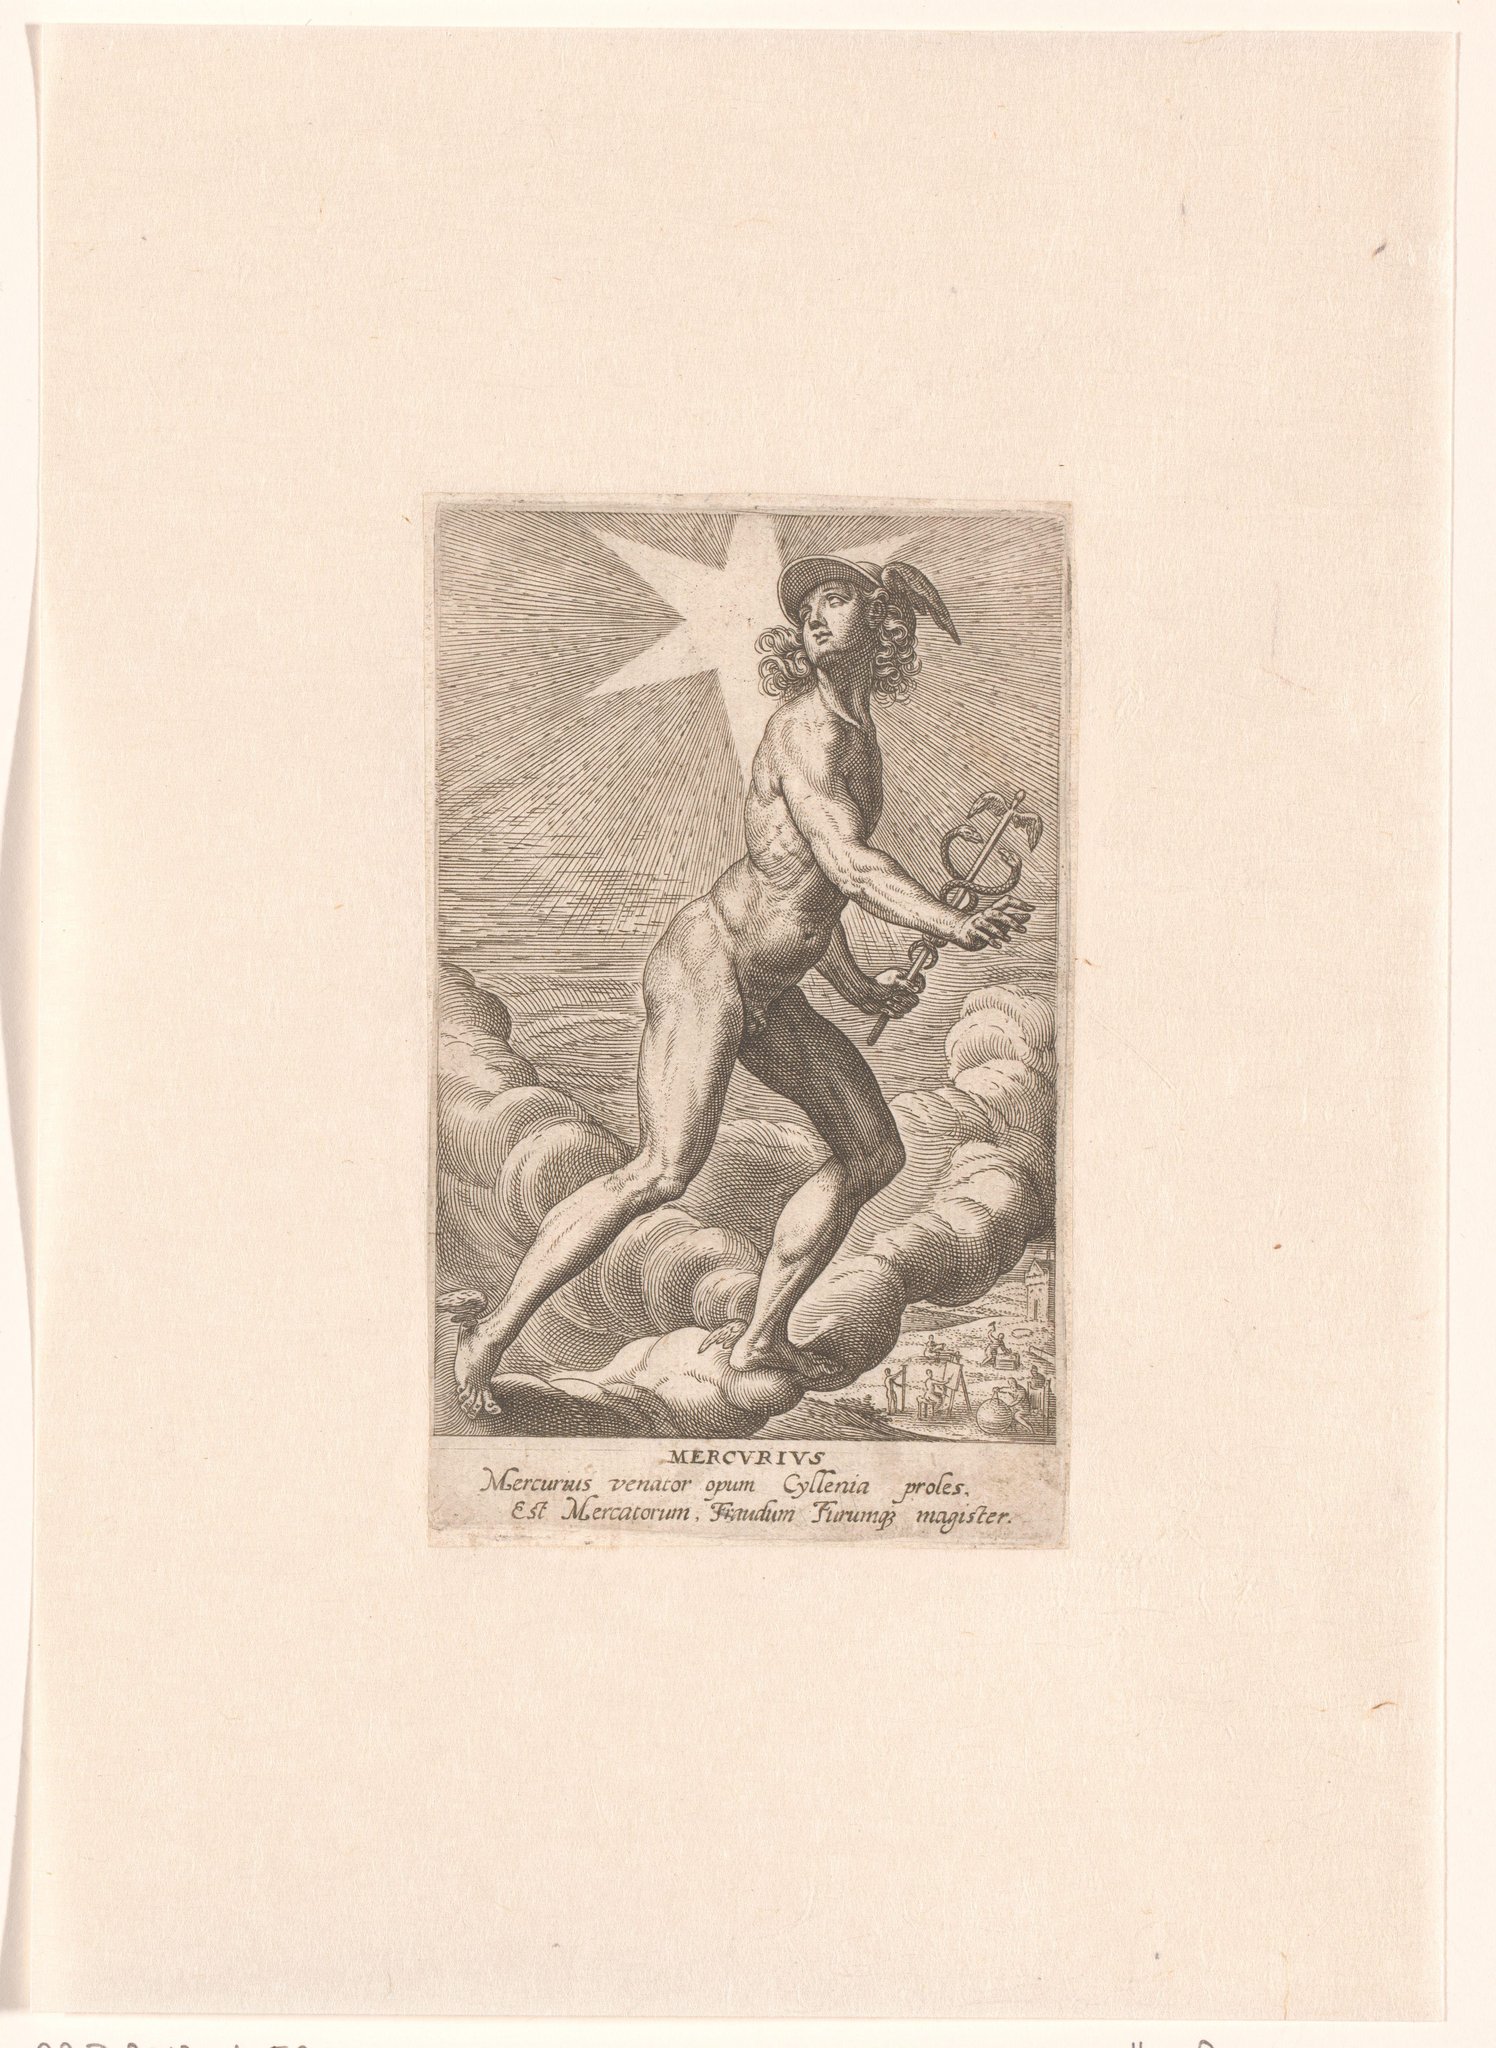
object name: print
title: De deis gentium imagines aliquot iconicae aeneis tabulis (...)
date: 1581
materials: paper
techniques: engraving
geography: antwerp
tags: (story of) mercury (hermes)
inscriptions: collector's mark: Lugt 2228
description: Mercurius met gevleugelde hoed, gevleugelde schoenen en de caduceus in zijn hand. In de ondermarge een tweeregelige Latijnse tekst.